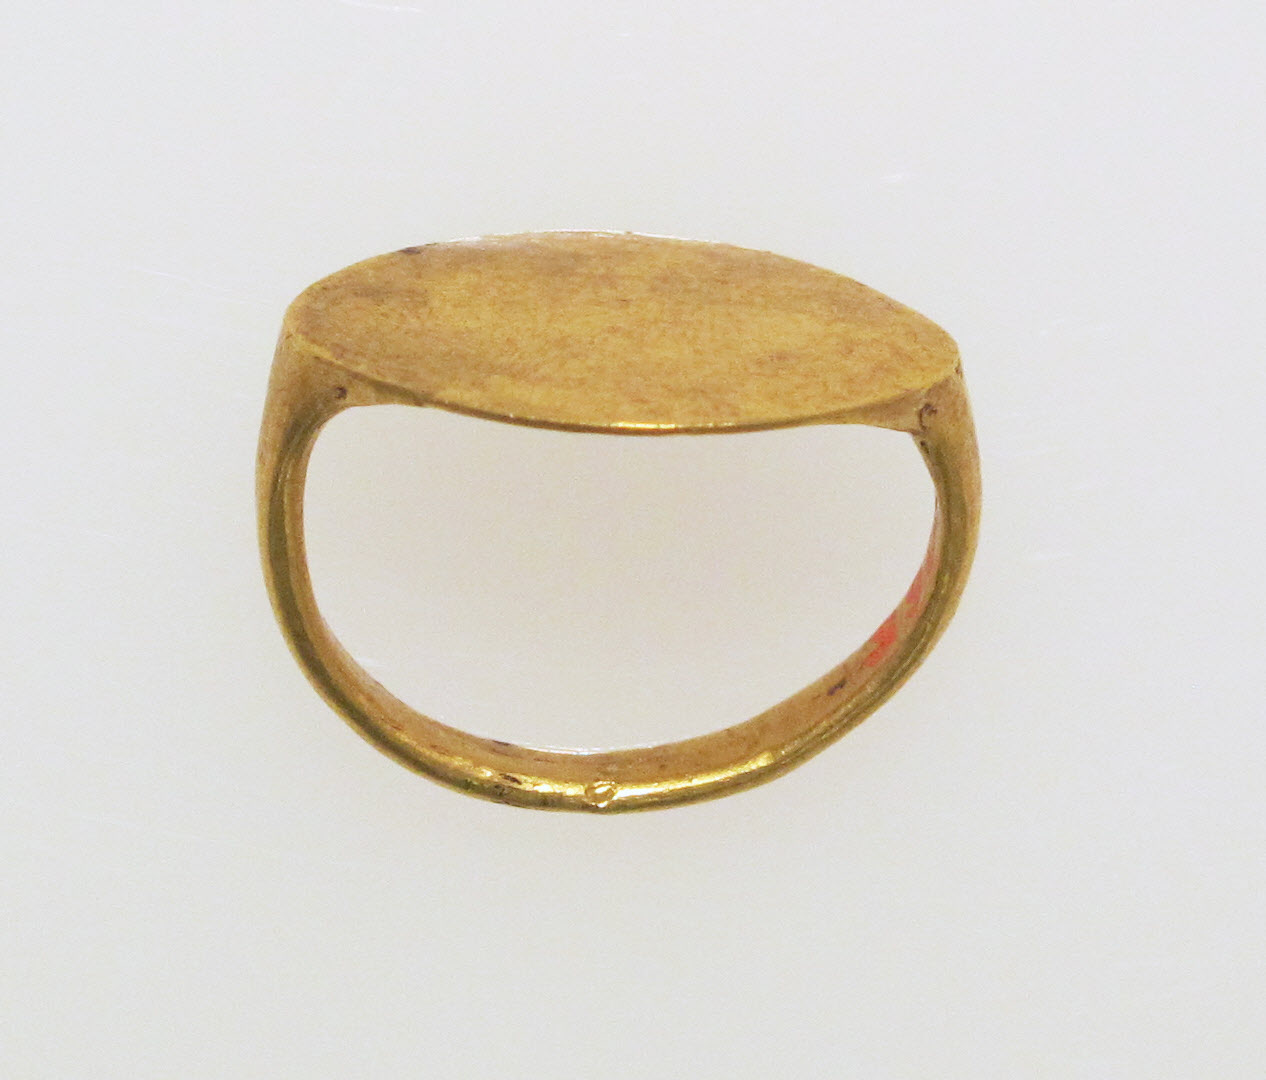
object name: ring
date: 7000 BCE-330 CE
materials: gold